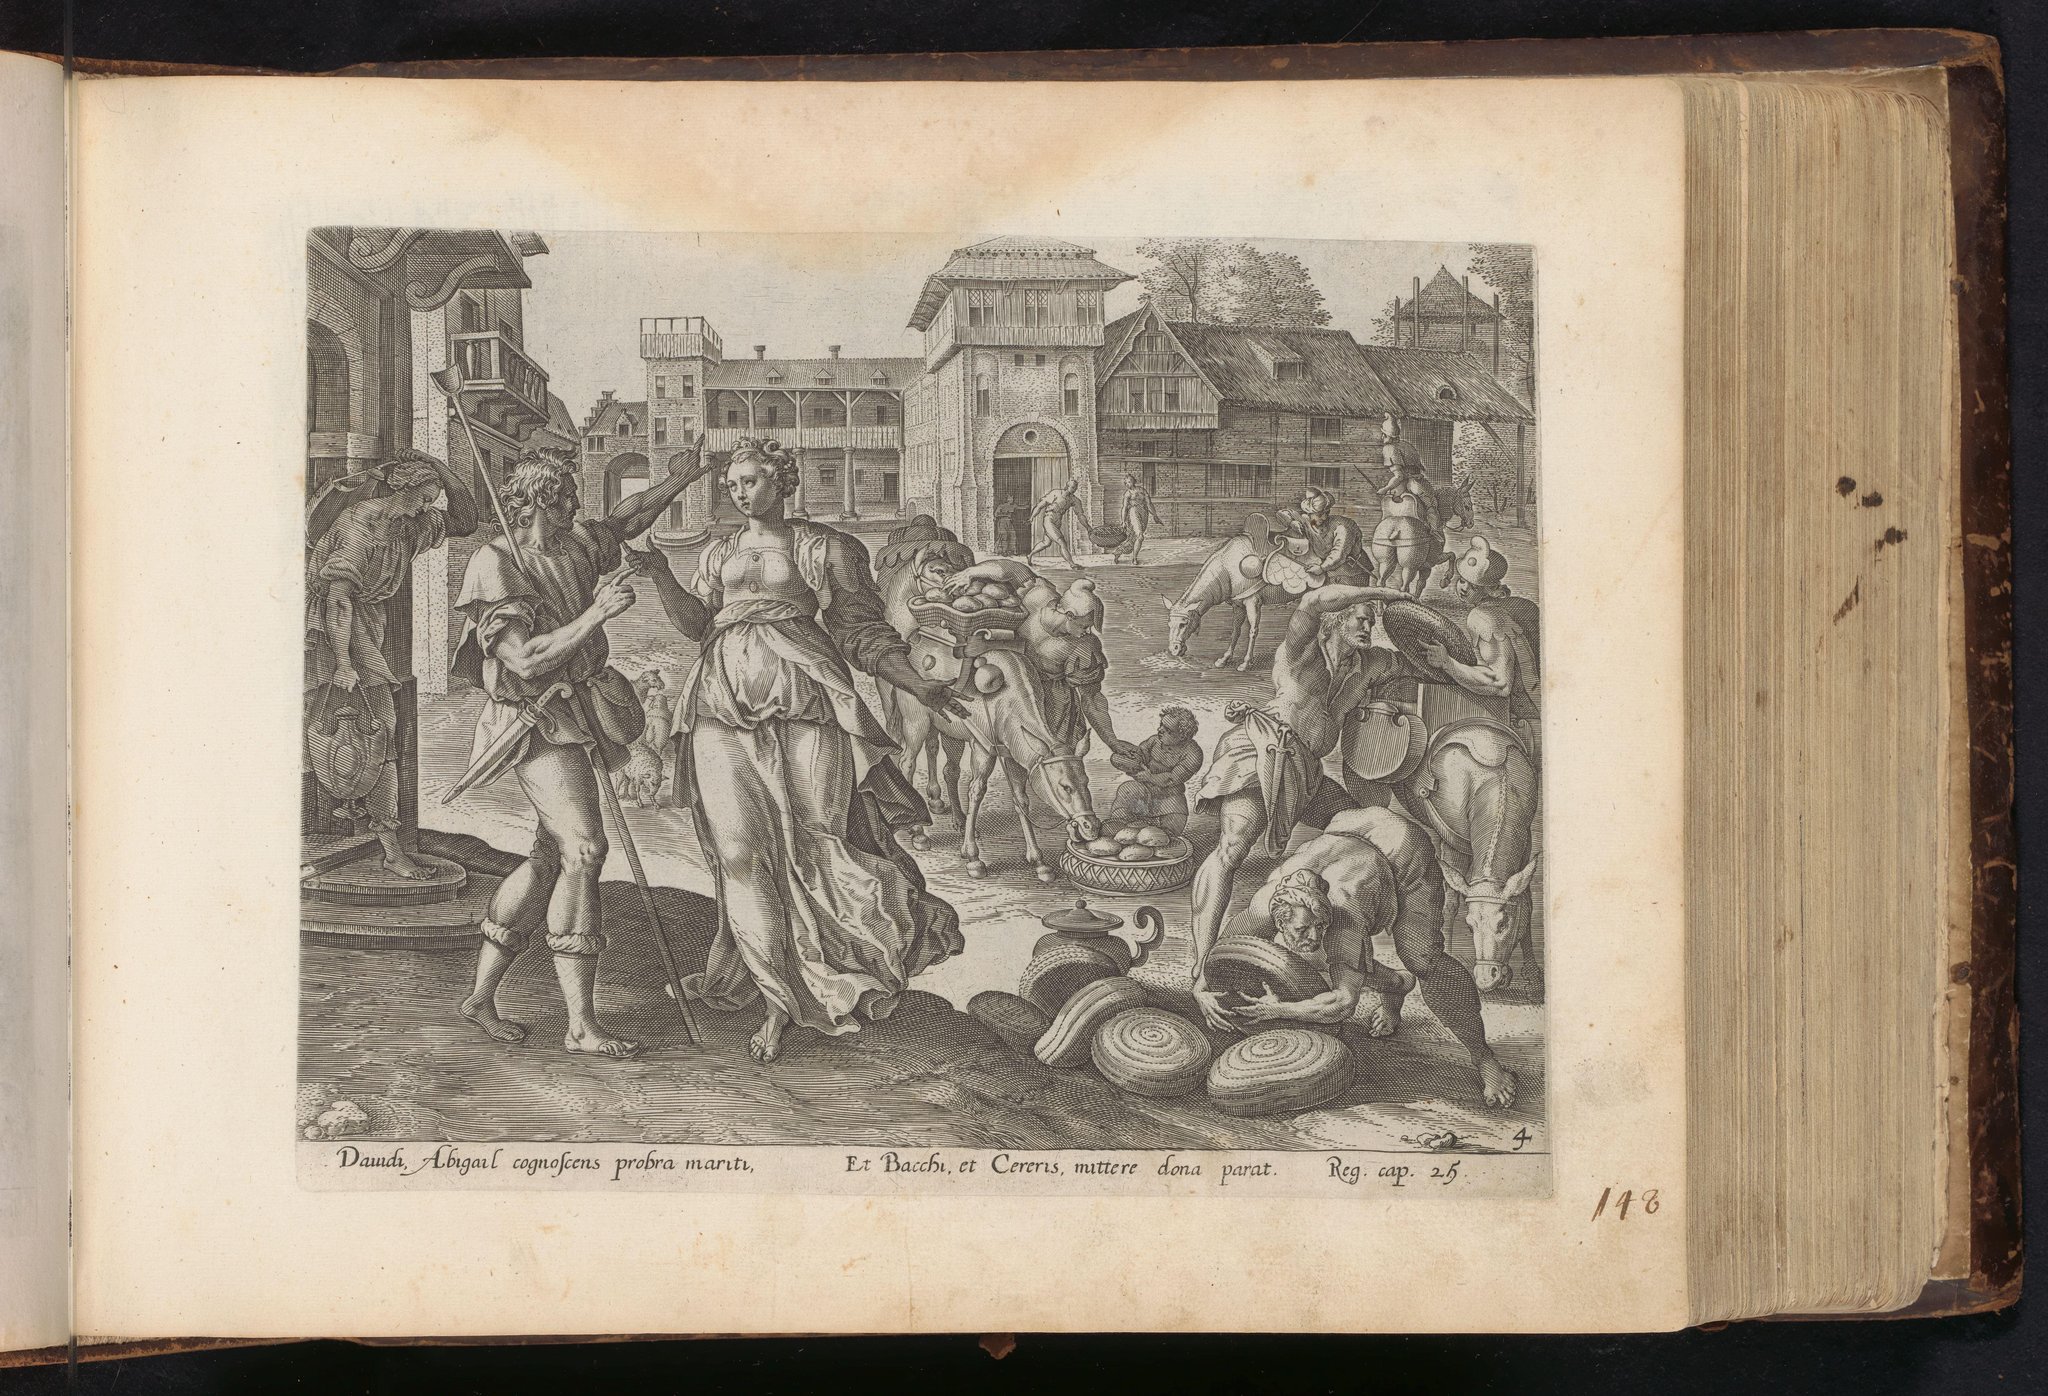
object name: print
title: Geschiedenis van David en Abigaïl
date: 1585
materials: paper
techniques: engraving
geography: amsterdam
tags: abigail goes out with asses laden with loaves of bread and bottles of wine, to meet david, ass, donkey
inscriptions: number: ‘148’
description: Abigaïl, de vrouw van Nabal, laat ezels bepakken met broden en kruiken wijn. Ze zal het voedsel naar David brengen. Abigaïl spreekt met een van haar knechten, die herder is. Onder de voorstelling een verwijzing in het Latijn naar de Bijbeltekst in 1 Sam. 25. Deze prent maakt deel uit van een album.